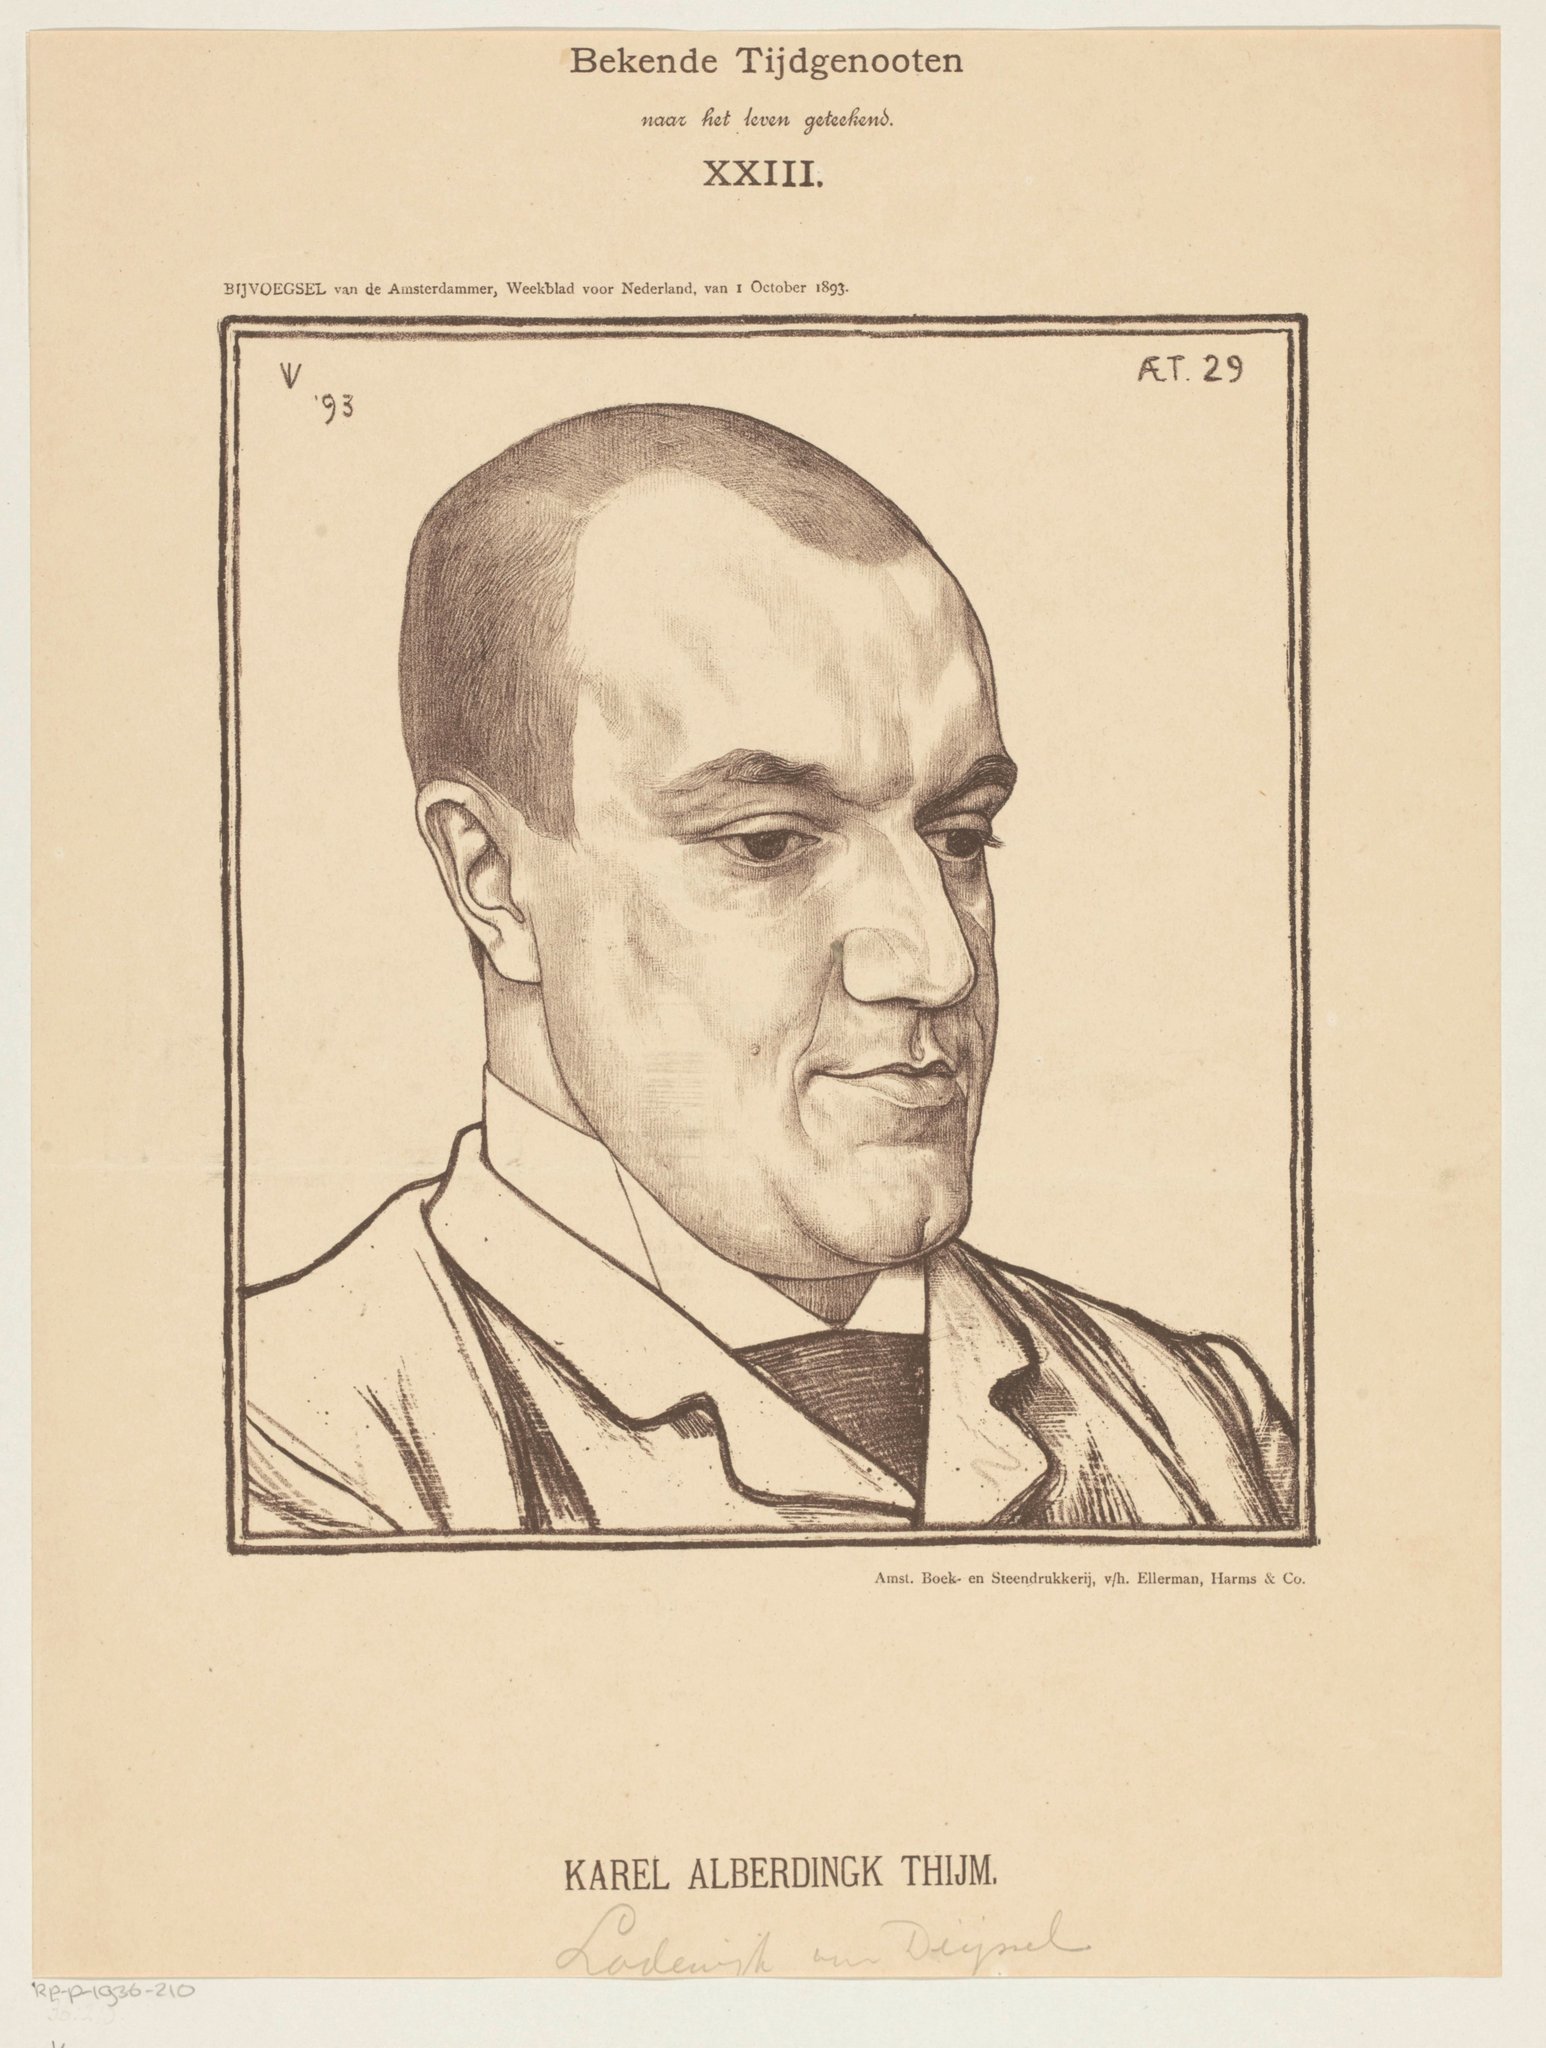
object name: print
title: Portret van Lodewijk van Deyssel op 29-jarige leeftijd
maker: jan veth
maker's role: designer, draughtsman, painter, print maker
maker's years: 1864-1925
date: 1893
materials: paper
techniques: letterpress printing, lithograph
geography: netherlands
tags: lodewijk van deyssel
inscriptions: collector's mark: Lugt 2228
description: Portret van Lodewijk van Deyssel in een rechthoekige omlijsting. Rechtsboven zijn leeftijd. In de bovenmarge drie regels Nederlandse tekst. In de ondermarge zijn naam.